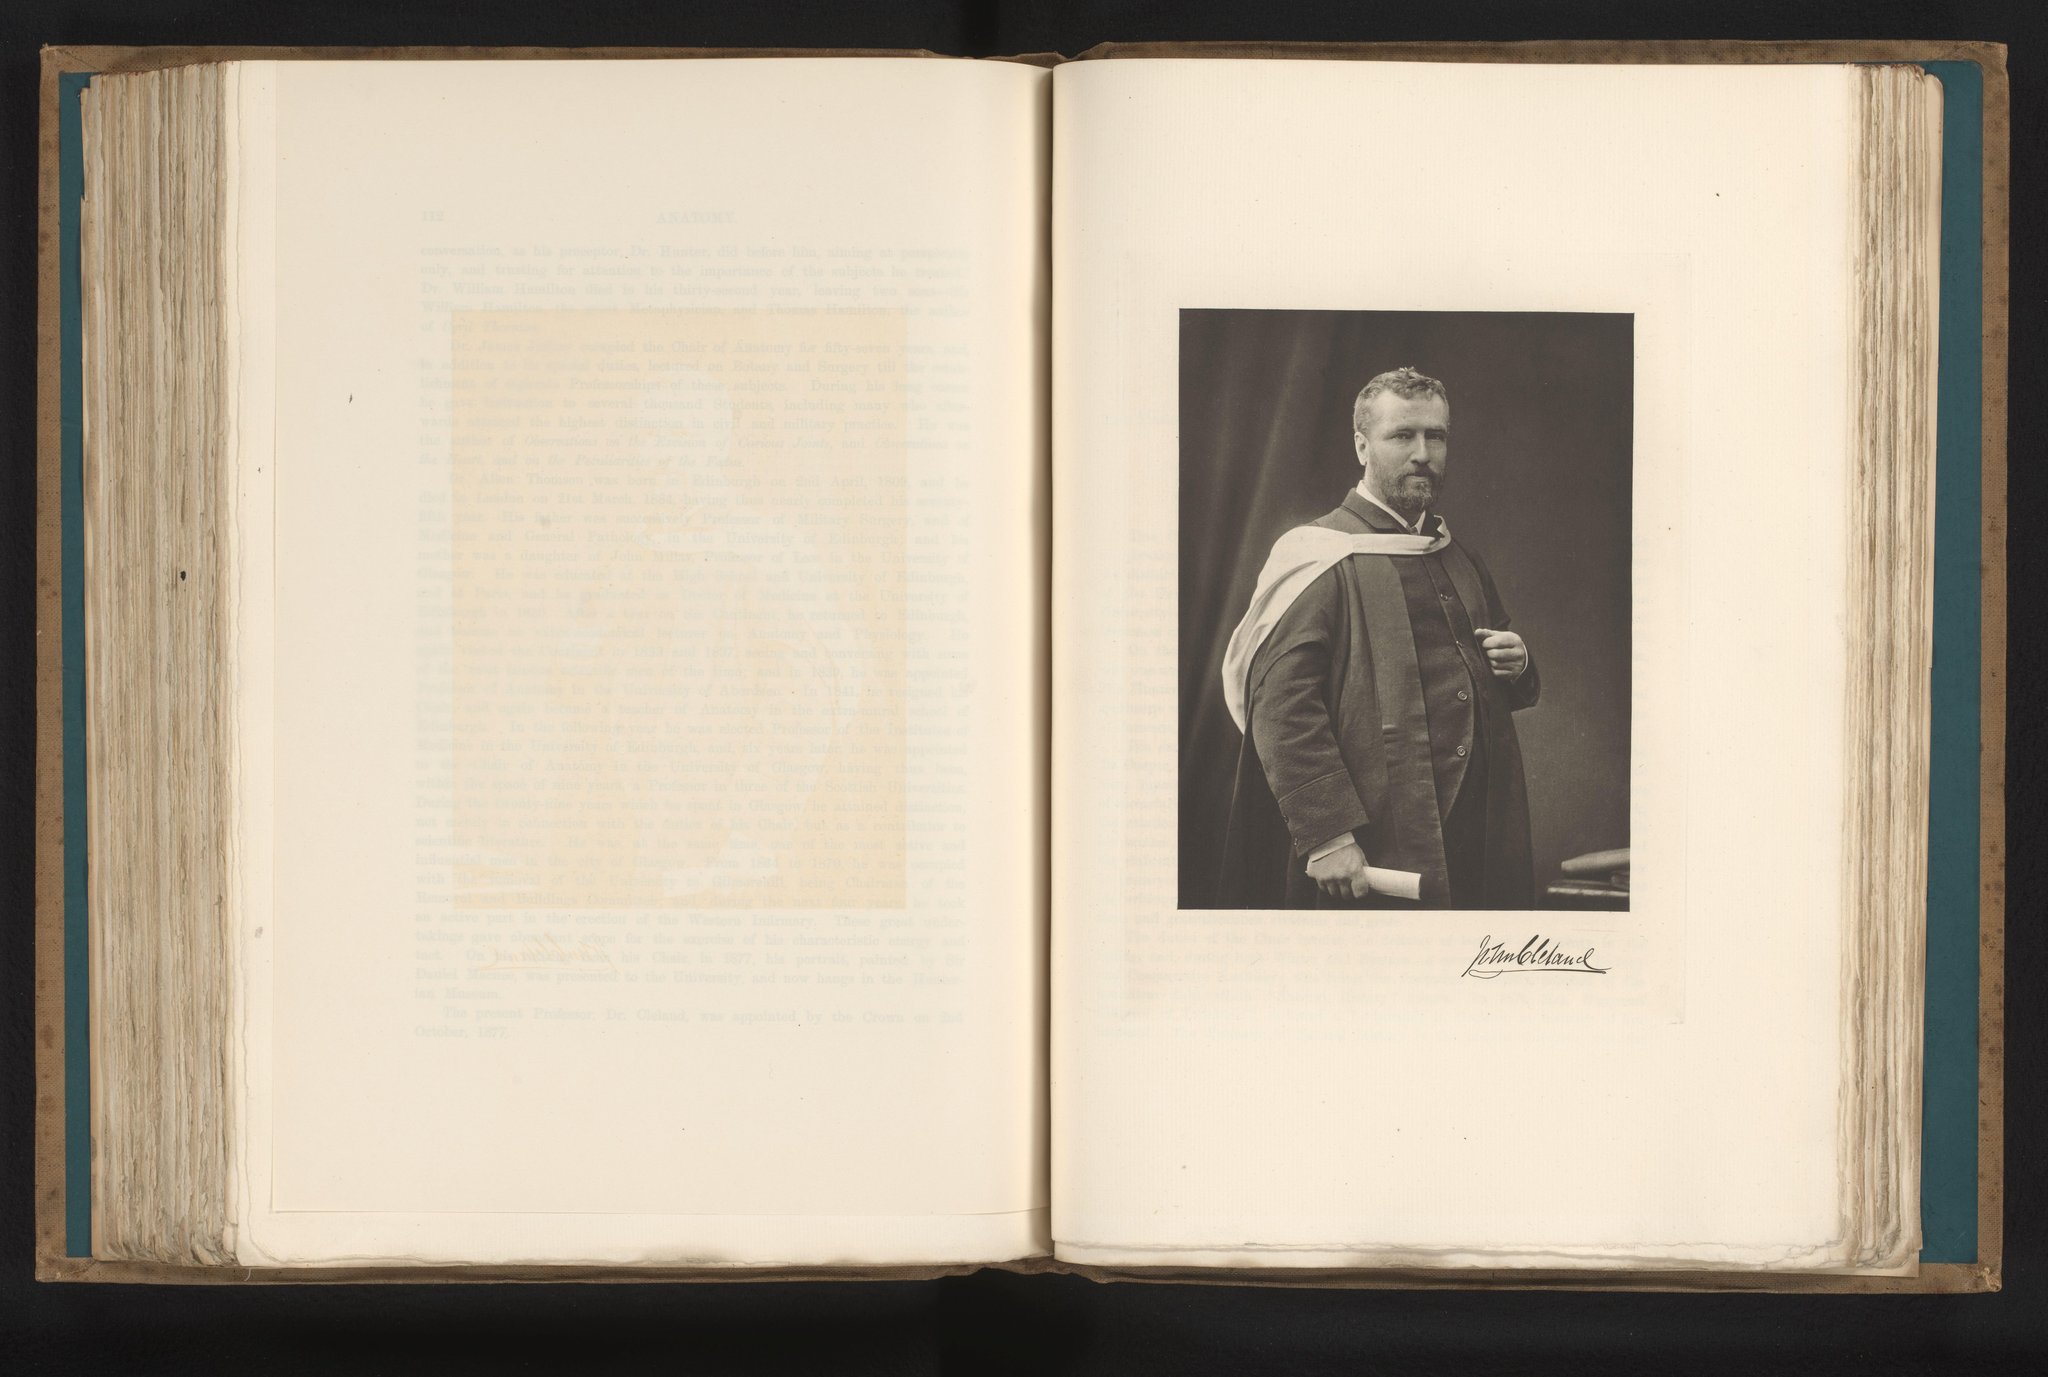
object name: photomechanical print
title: Portret van John Cleland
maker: Anonymous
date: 1886-1891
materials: paper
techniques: photoaquatint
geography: glasgow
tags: historical persons, physician, doctor, professor